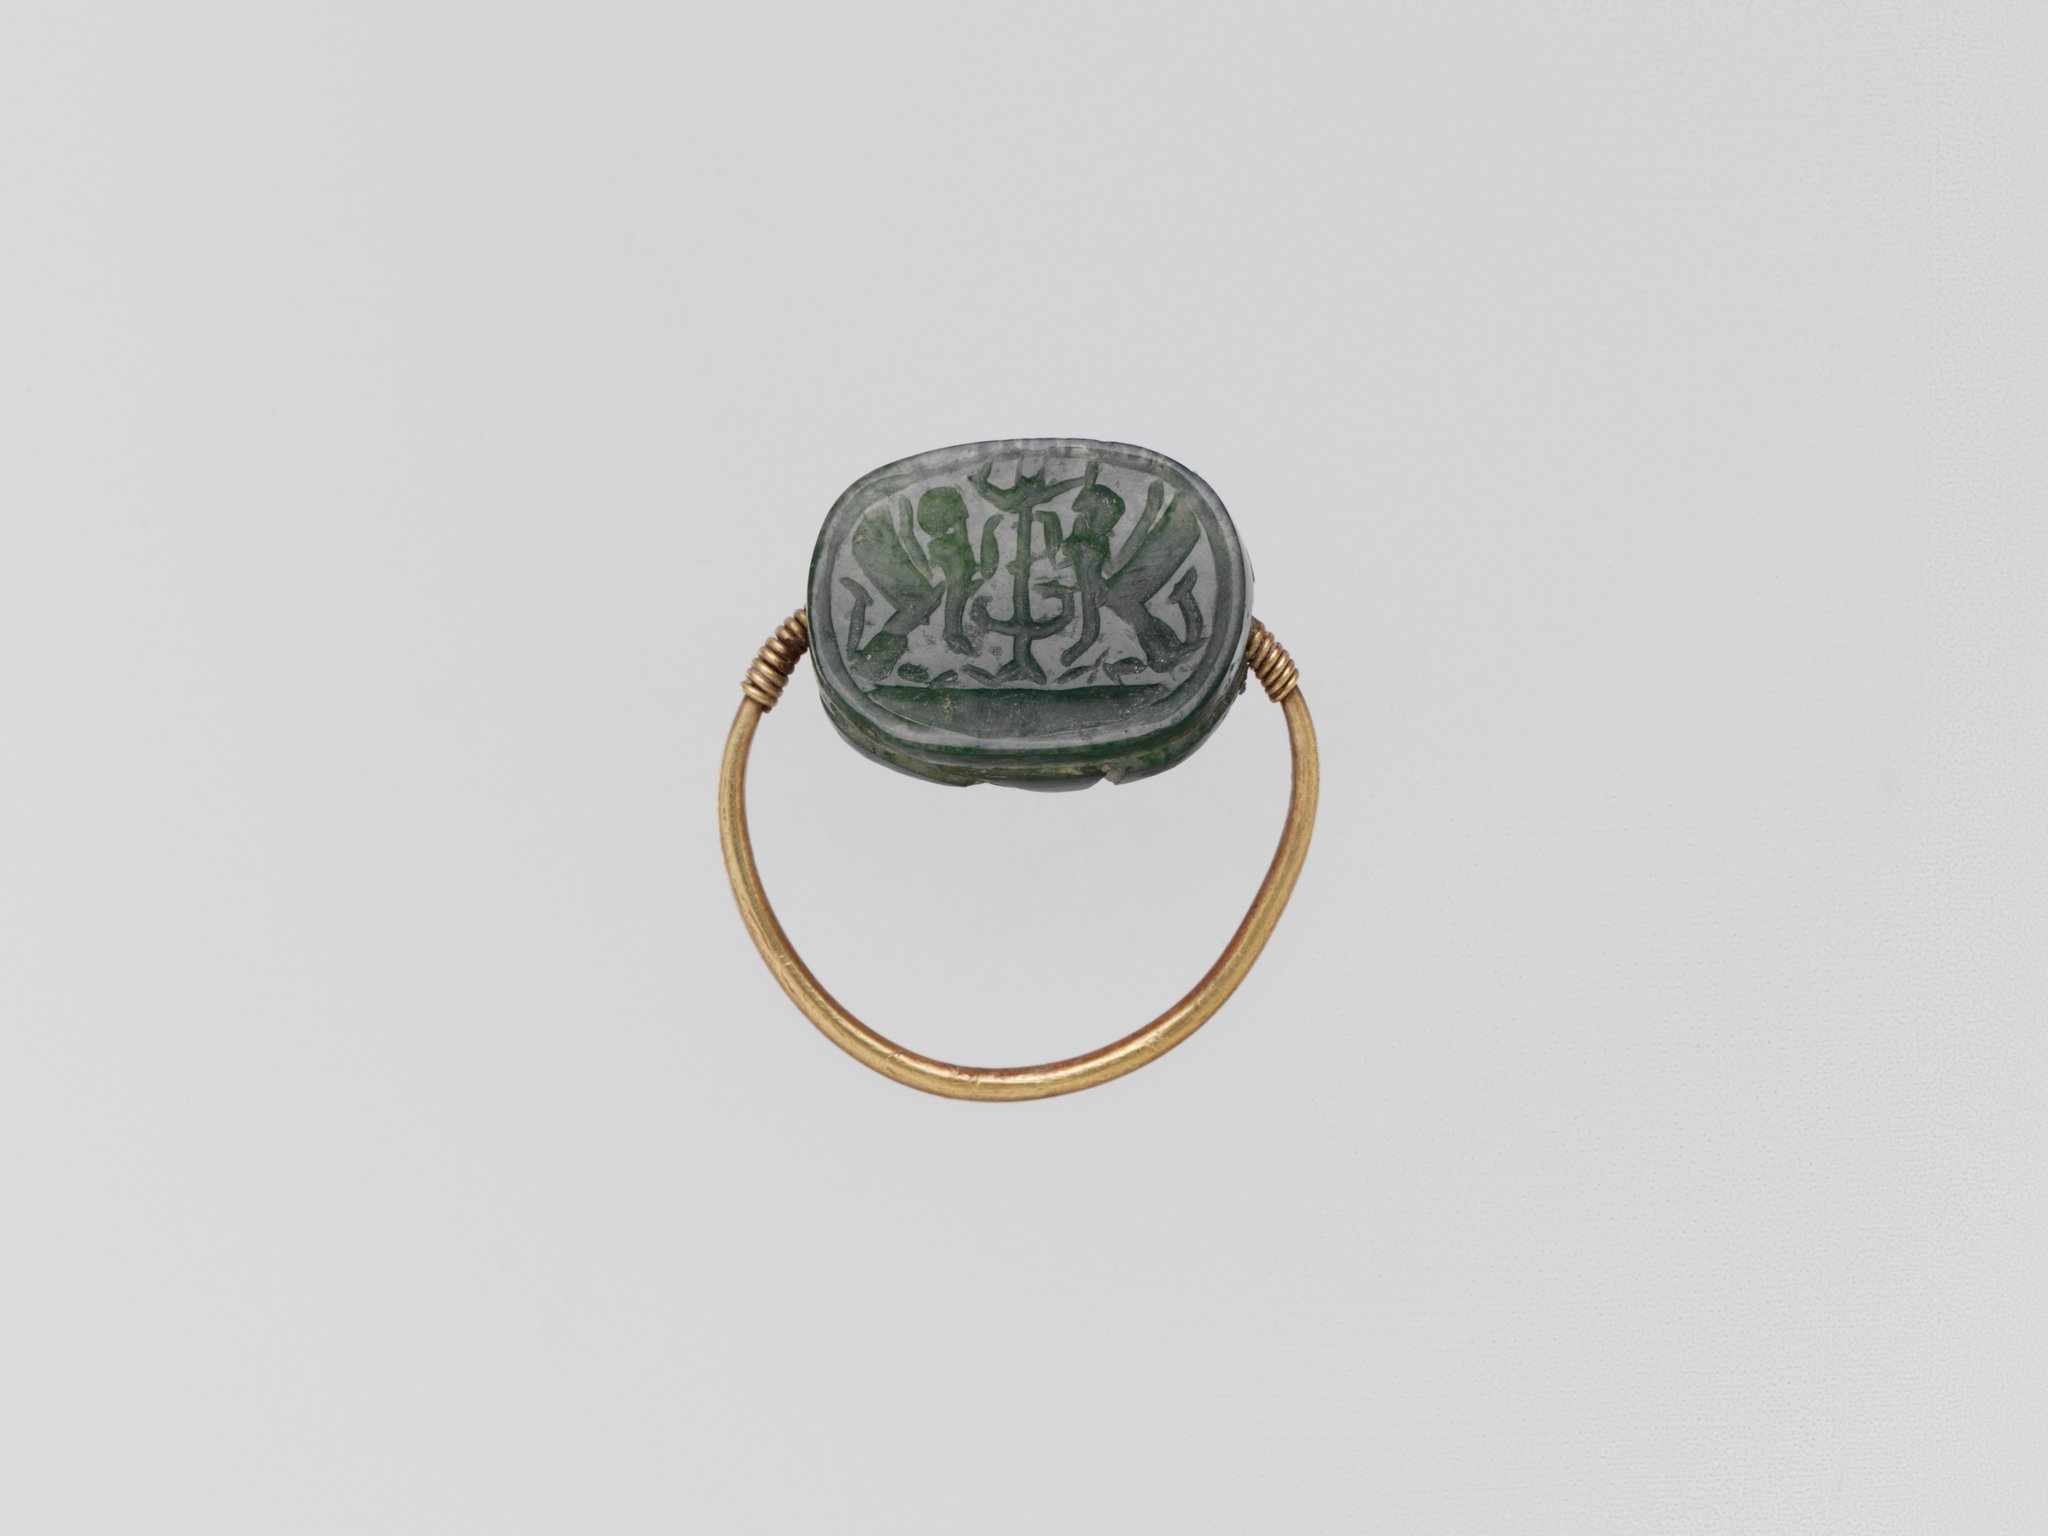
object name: ring with scarab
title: Gold hoop with plasma scarab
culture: cypriot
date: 600-401 BCE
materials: gold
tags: sphinx